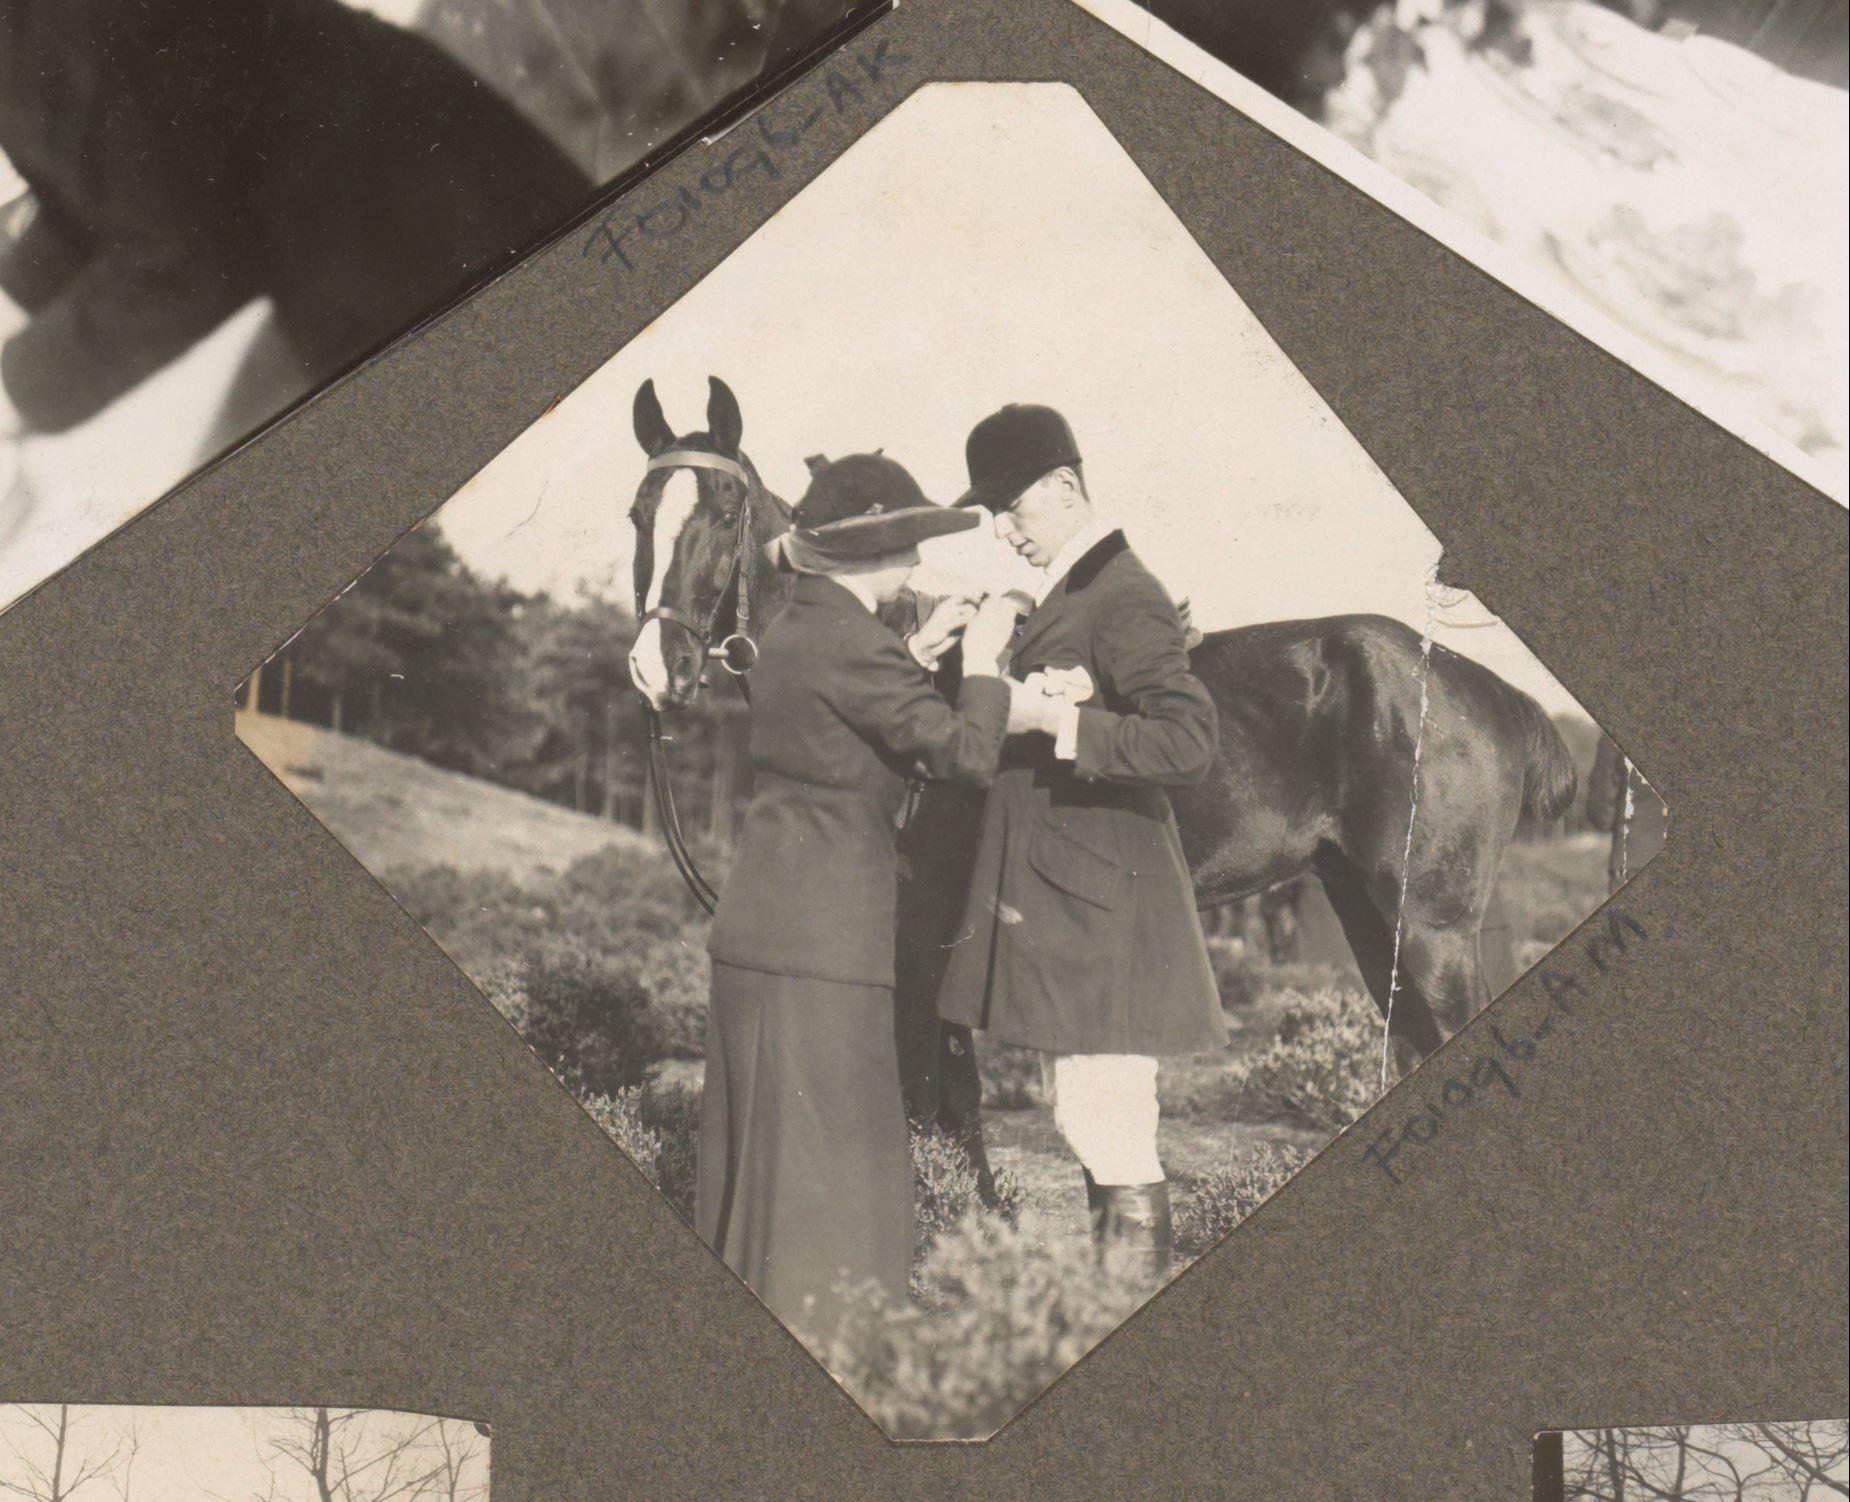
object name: photograph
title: Ruitertafereel op Koninklijke Houtvesterij Het Loo: vrouw speldt ruiter iets op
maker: Anonymous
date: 1900-1925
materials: photographic support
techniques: gelatin silver print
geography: het loo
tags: riding a horse, ass, or mule; rider, horseman, hunting, chase, hunting-ground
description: Onderdeel van Fotoalbum van de heer Brams, opperhoutvester van koningin Wilhelmina op Koninklijke Houtvesterij Het Loo.